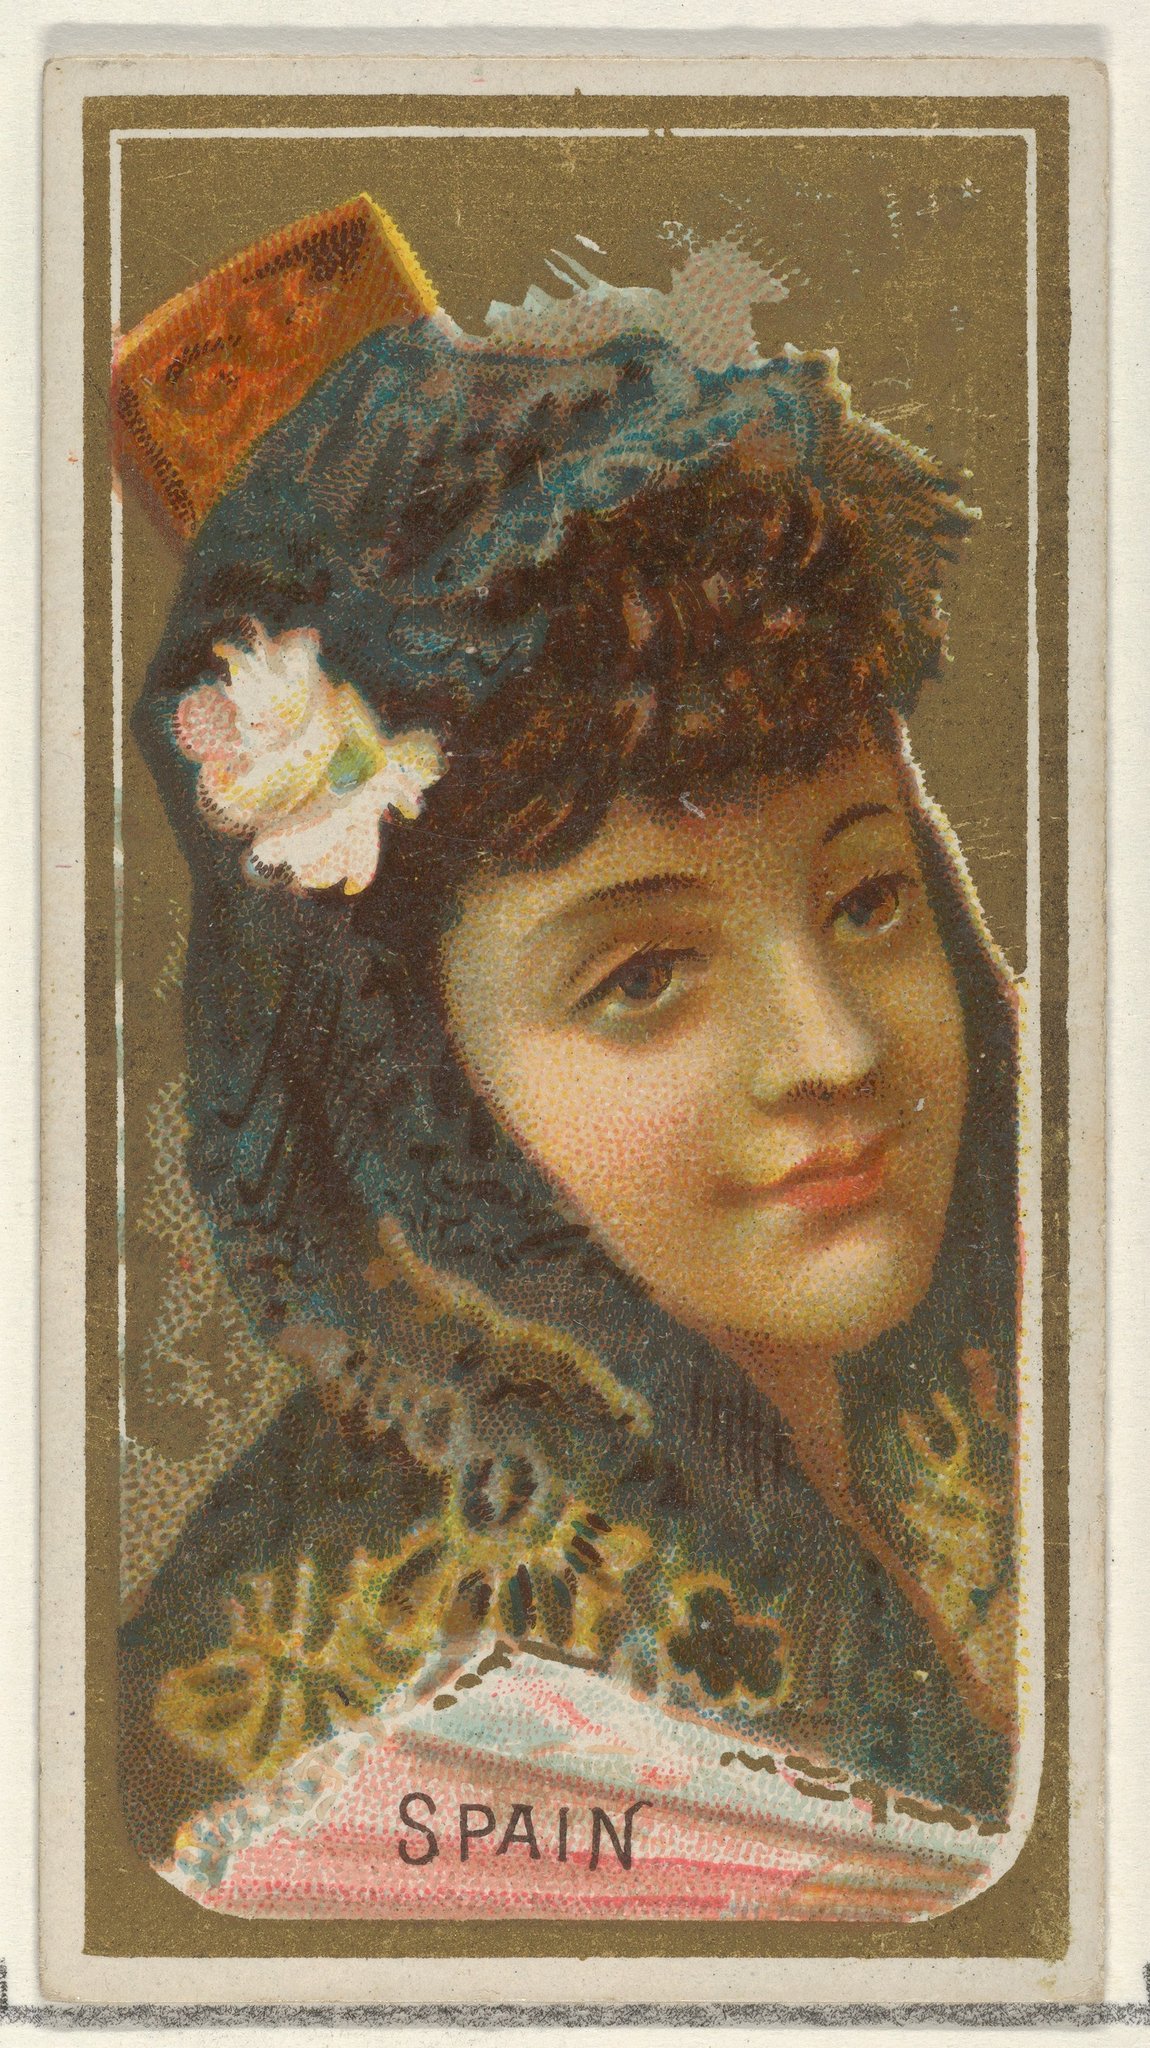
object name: print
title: Spain, from the Types of All Nations series (N24) for Allen & Ginter Cigarettes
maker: allen & ginter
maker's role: publisher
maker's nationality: american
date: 1889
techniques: color lithograph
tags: women